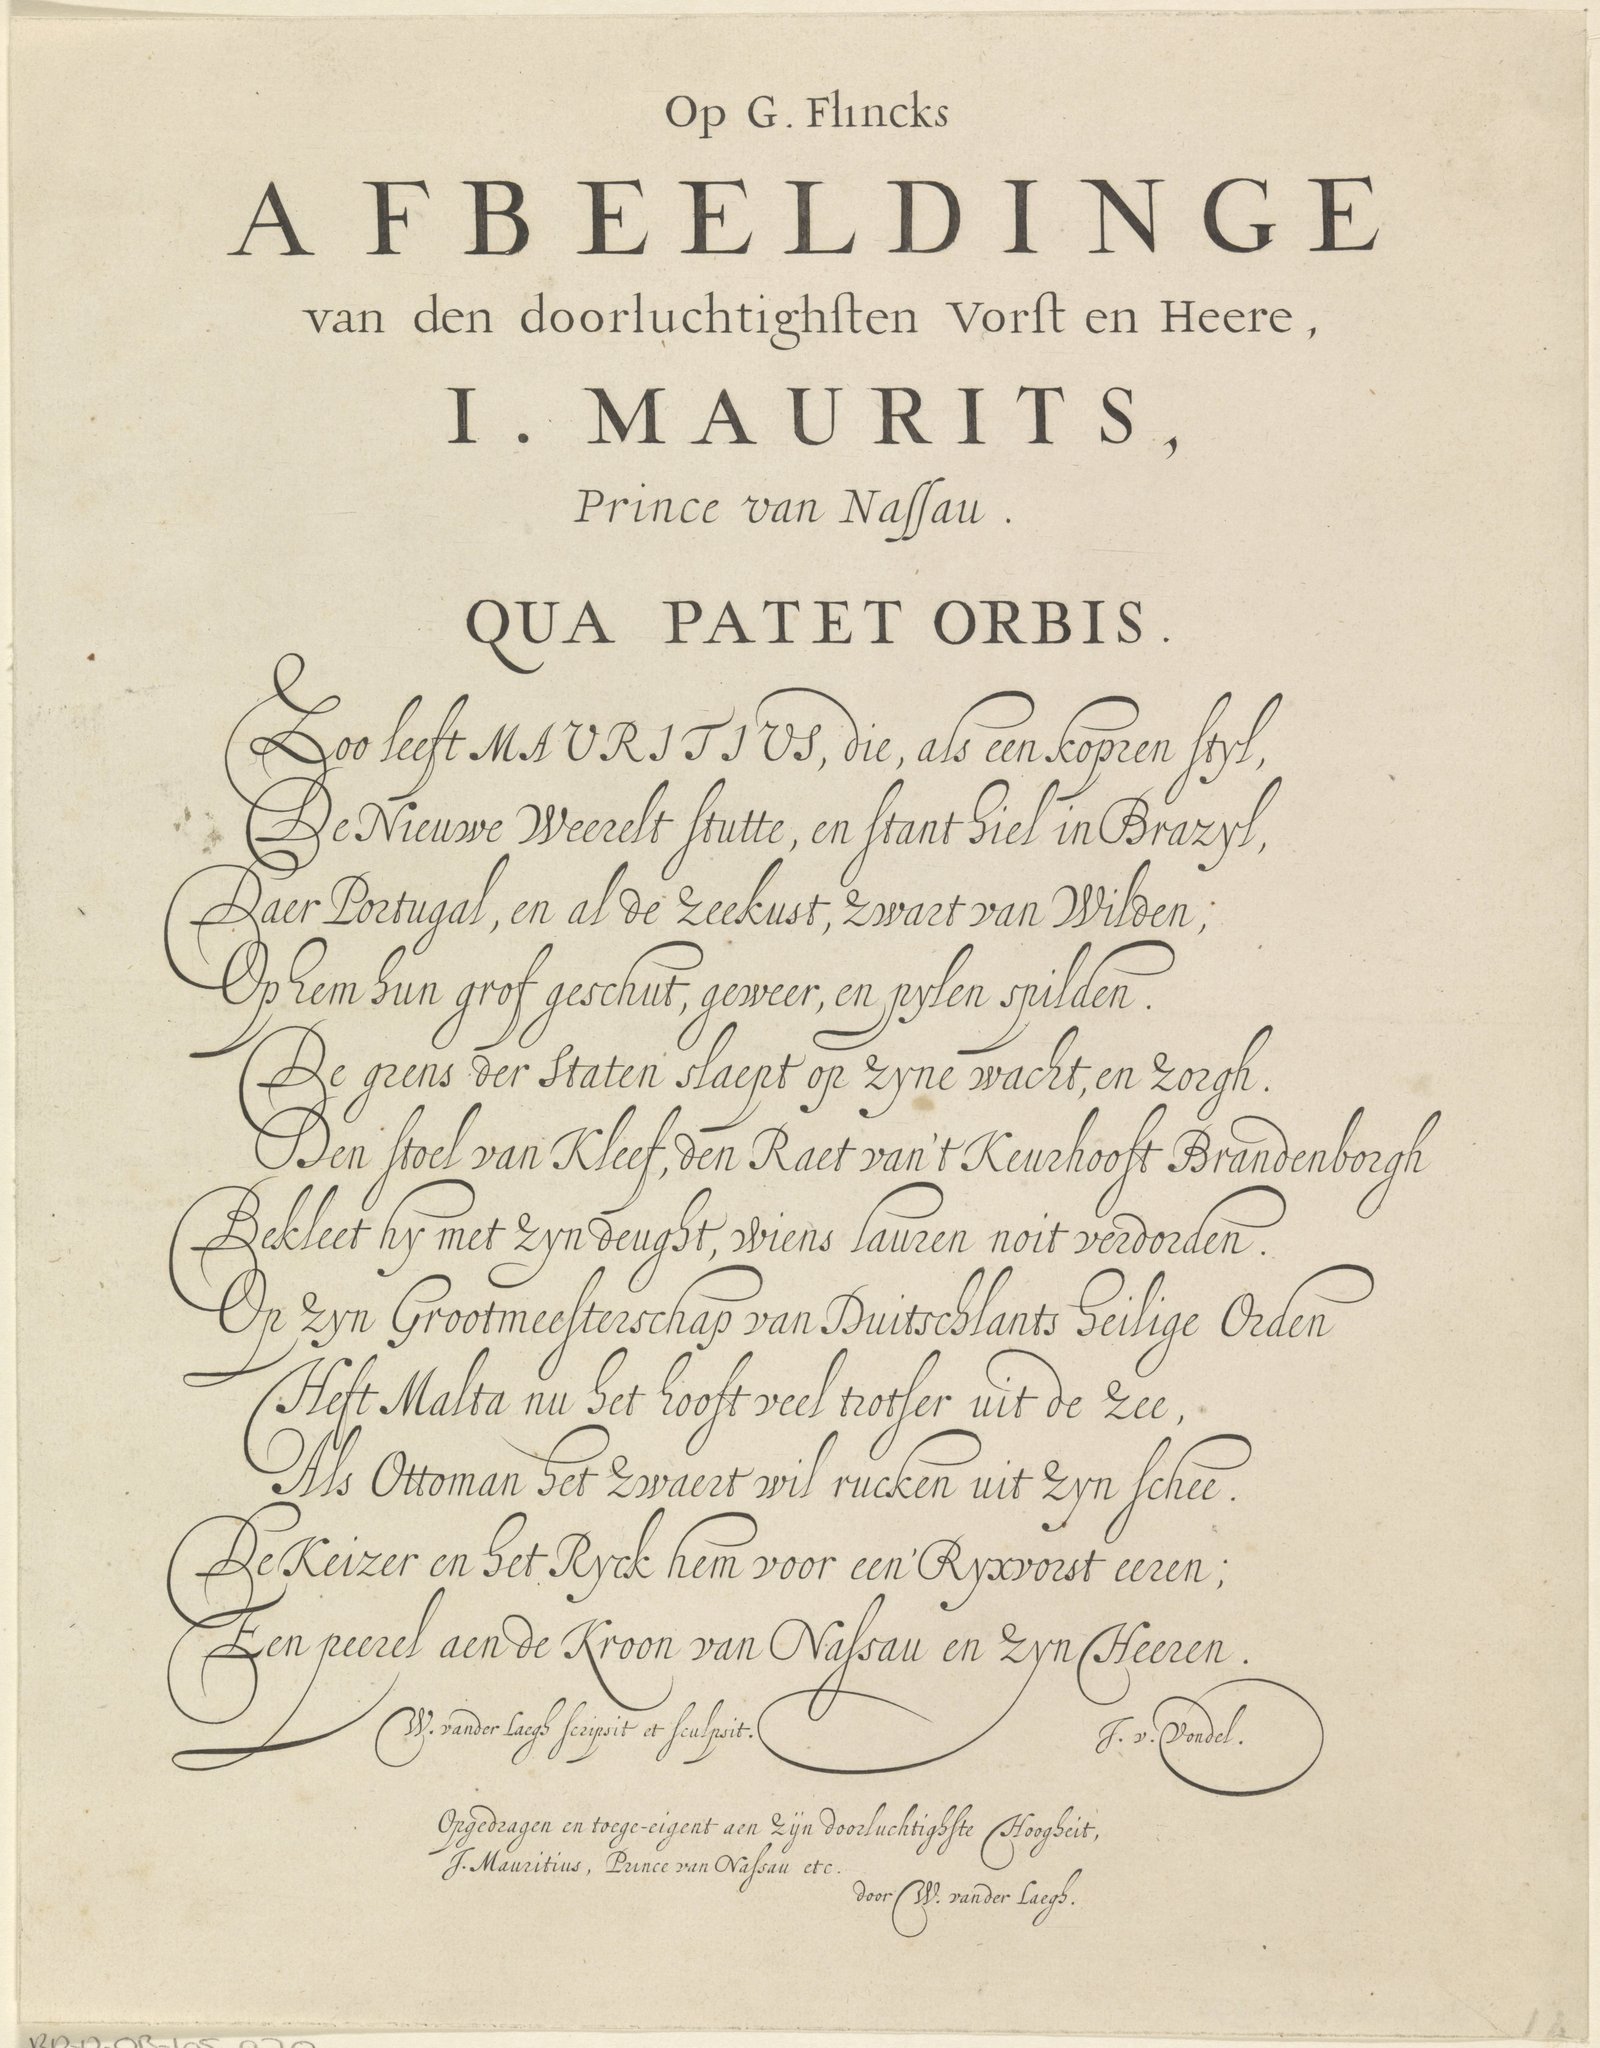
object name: text sheet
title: Tekst bij het portret van Johan Maurits, graaf van Nassau-Siegen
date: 1624-1694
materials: paper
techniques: engraving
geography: amsterdam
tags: earl, johan maurits graaf van nassau-siegen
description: De hier vermelde titel verwijst naar de hoogst verkregen titel van de geportretteerde, niet per se naar de titel die de geportretteerde op deze voorstelling draagt.